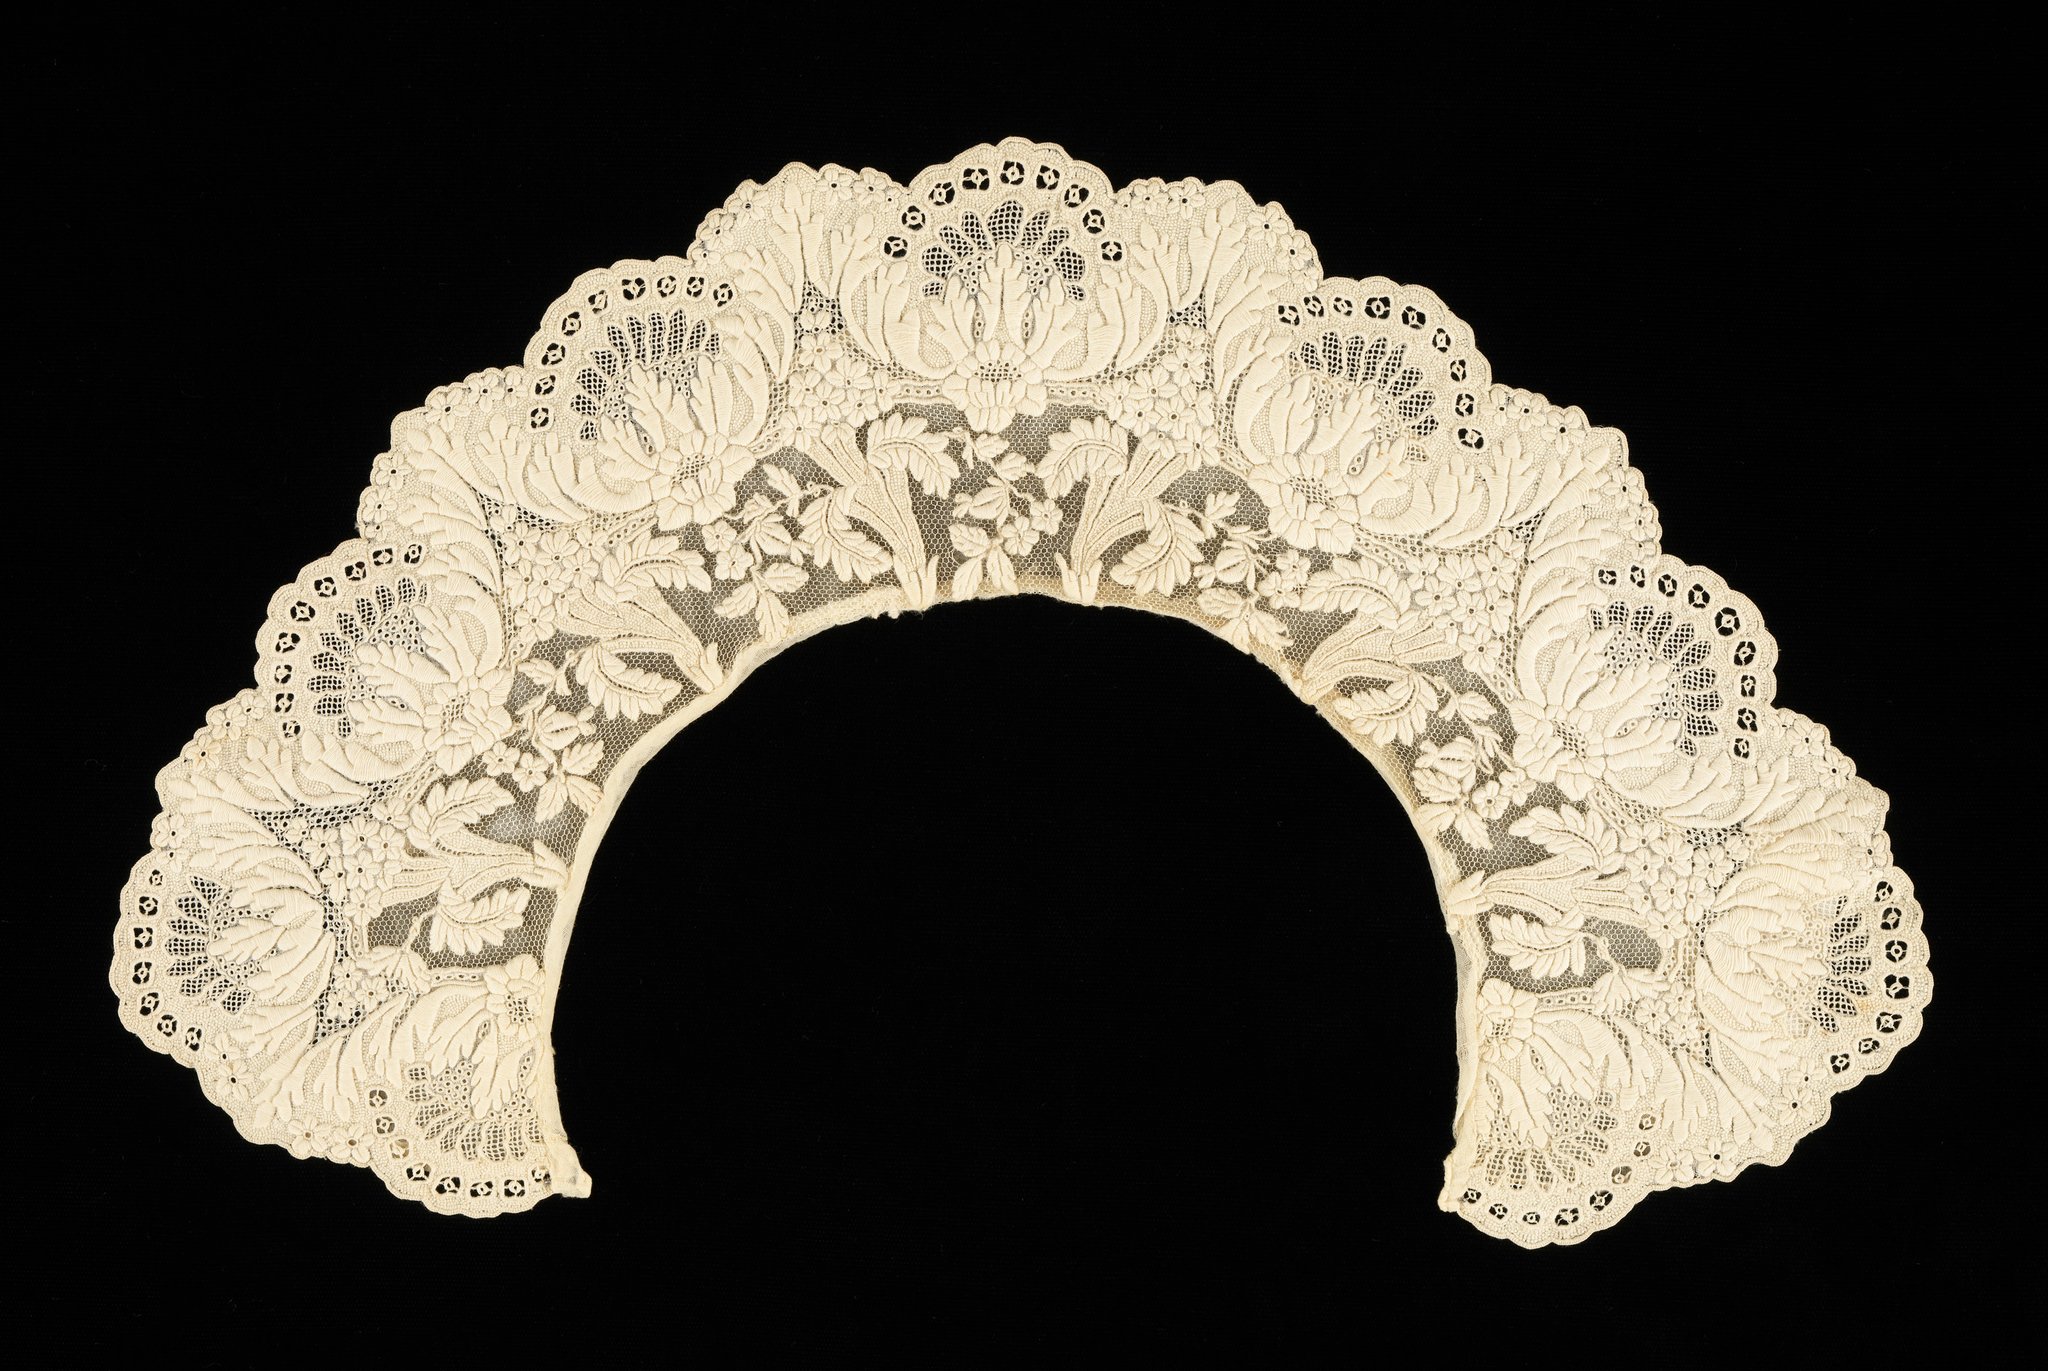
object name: collar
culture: european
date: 1850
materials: cotton